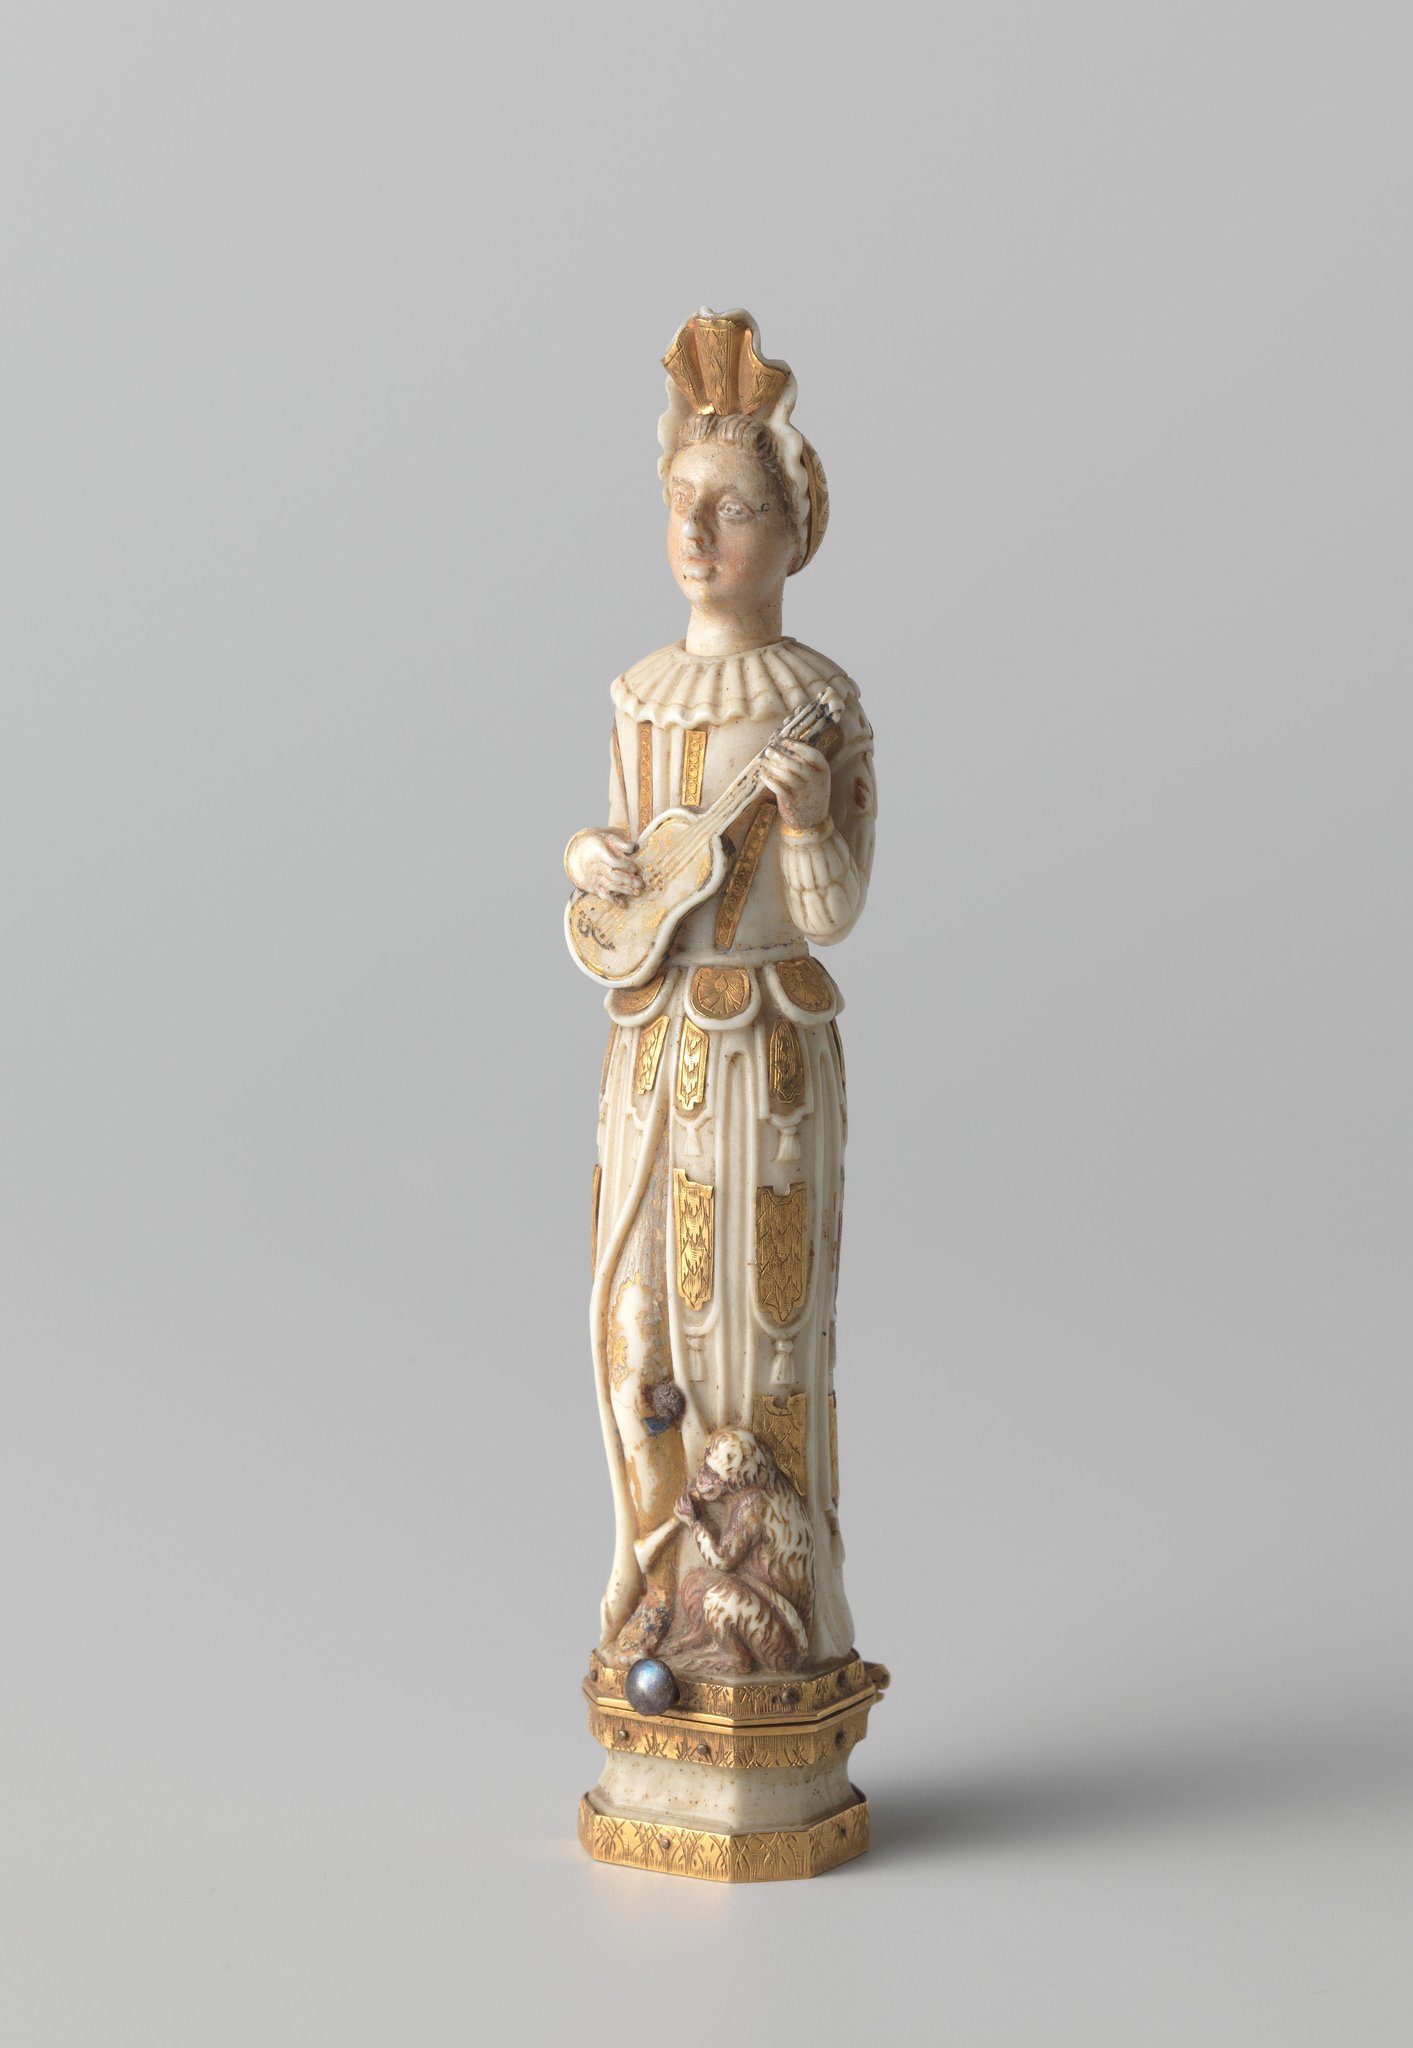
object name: needle case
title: Woman Playing the Guitar, Needle Case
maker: Anonymous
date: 1700-1799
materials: ivory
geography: germany